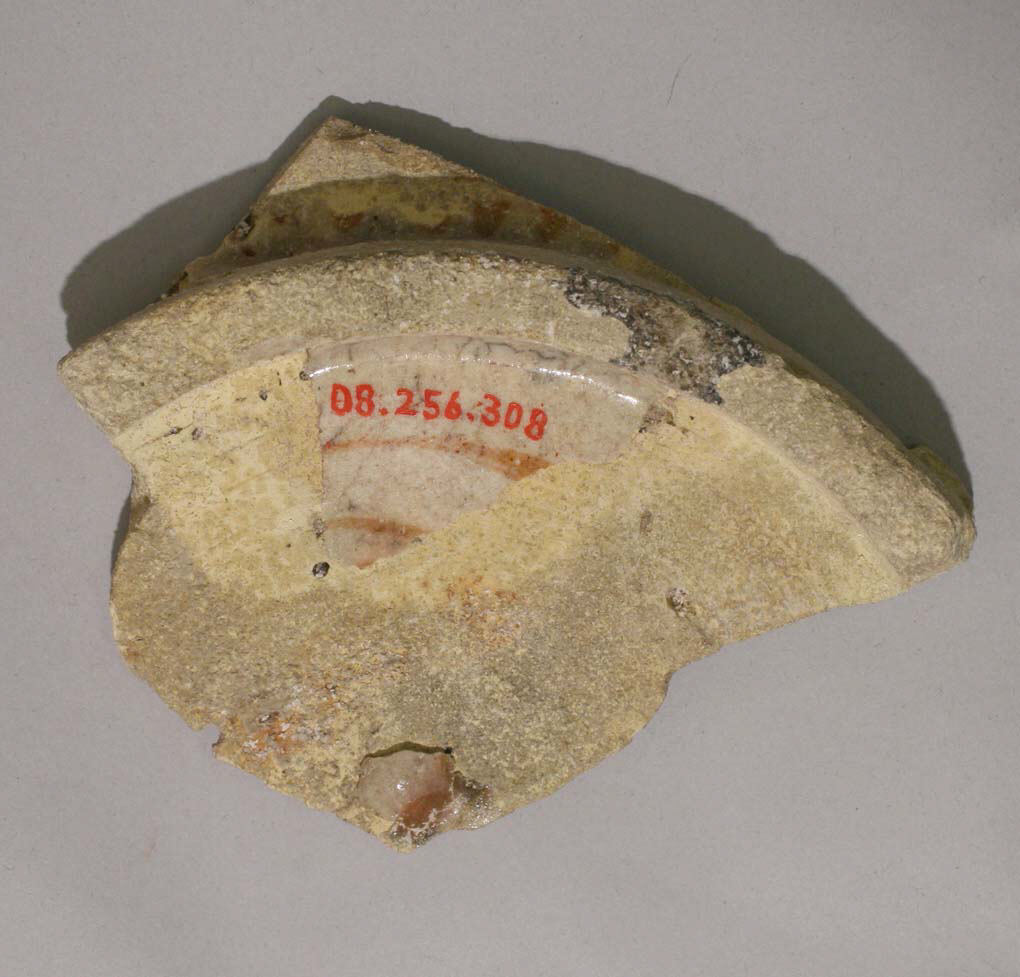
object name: fragment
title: Ceramic Fragment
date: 801-1300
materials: earthenware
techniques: glazing, luster painting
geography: iraq